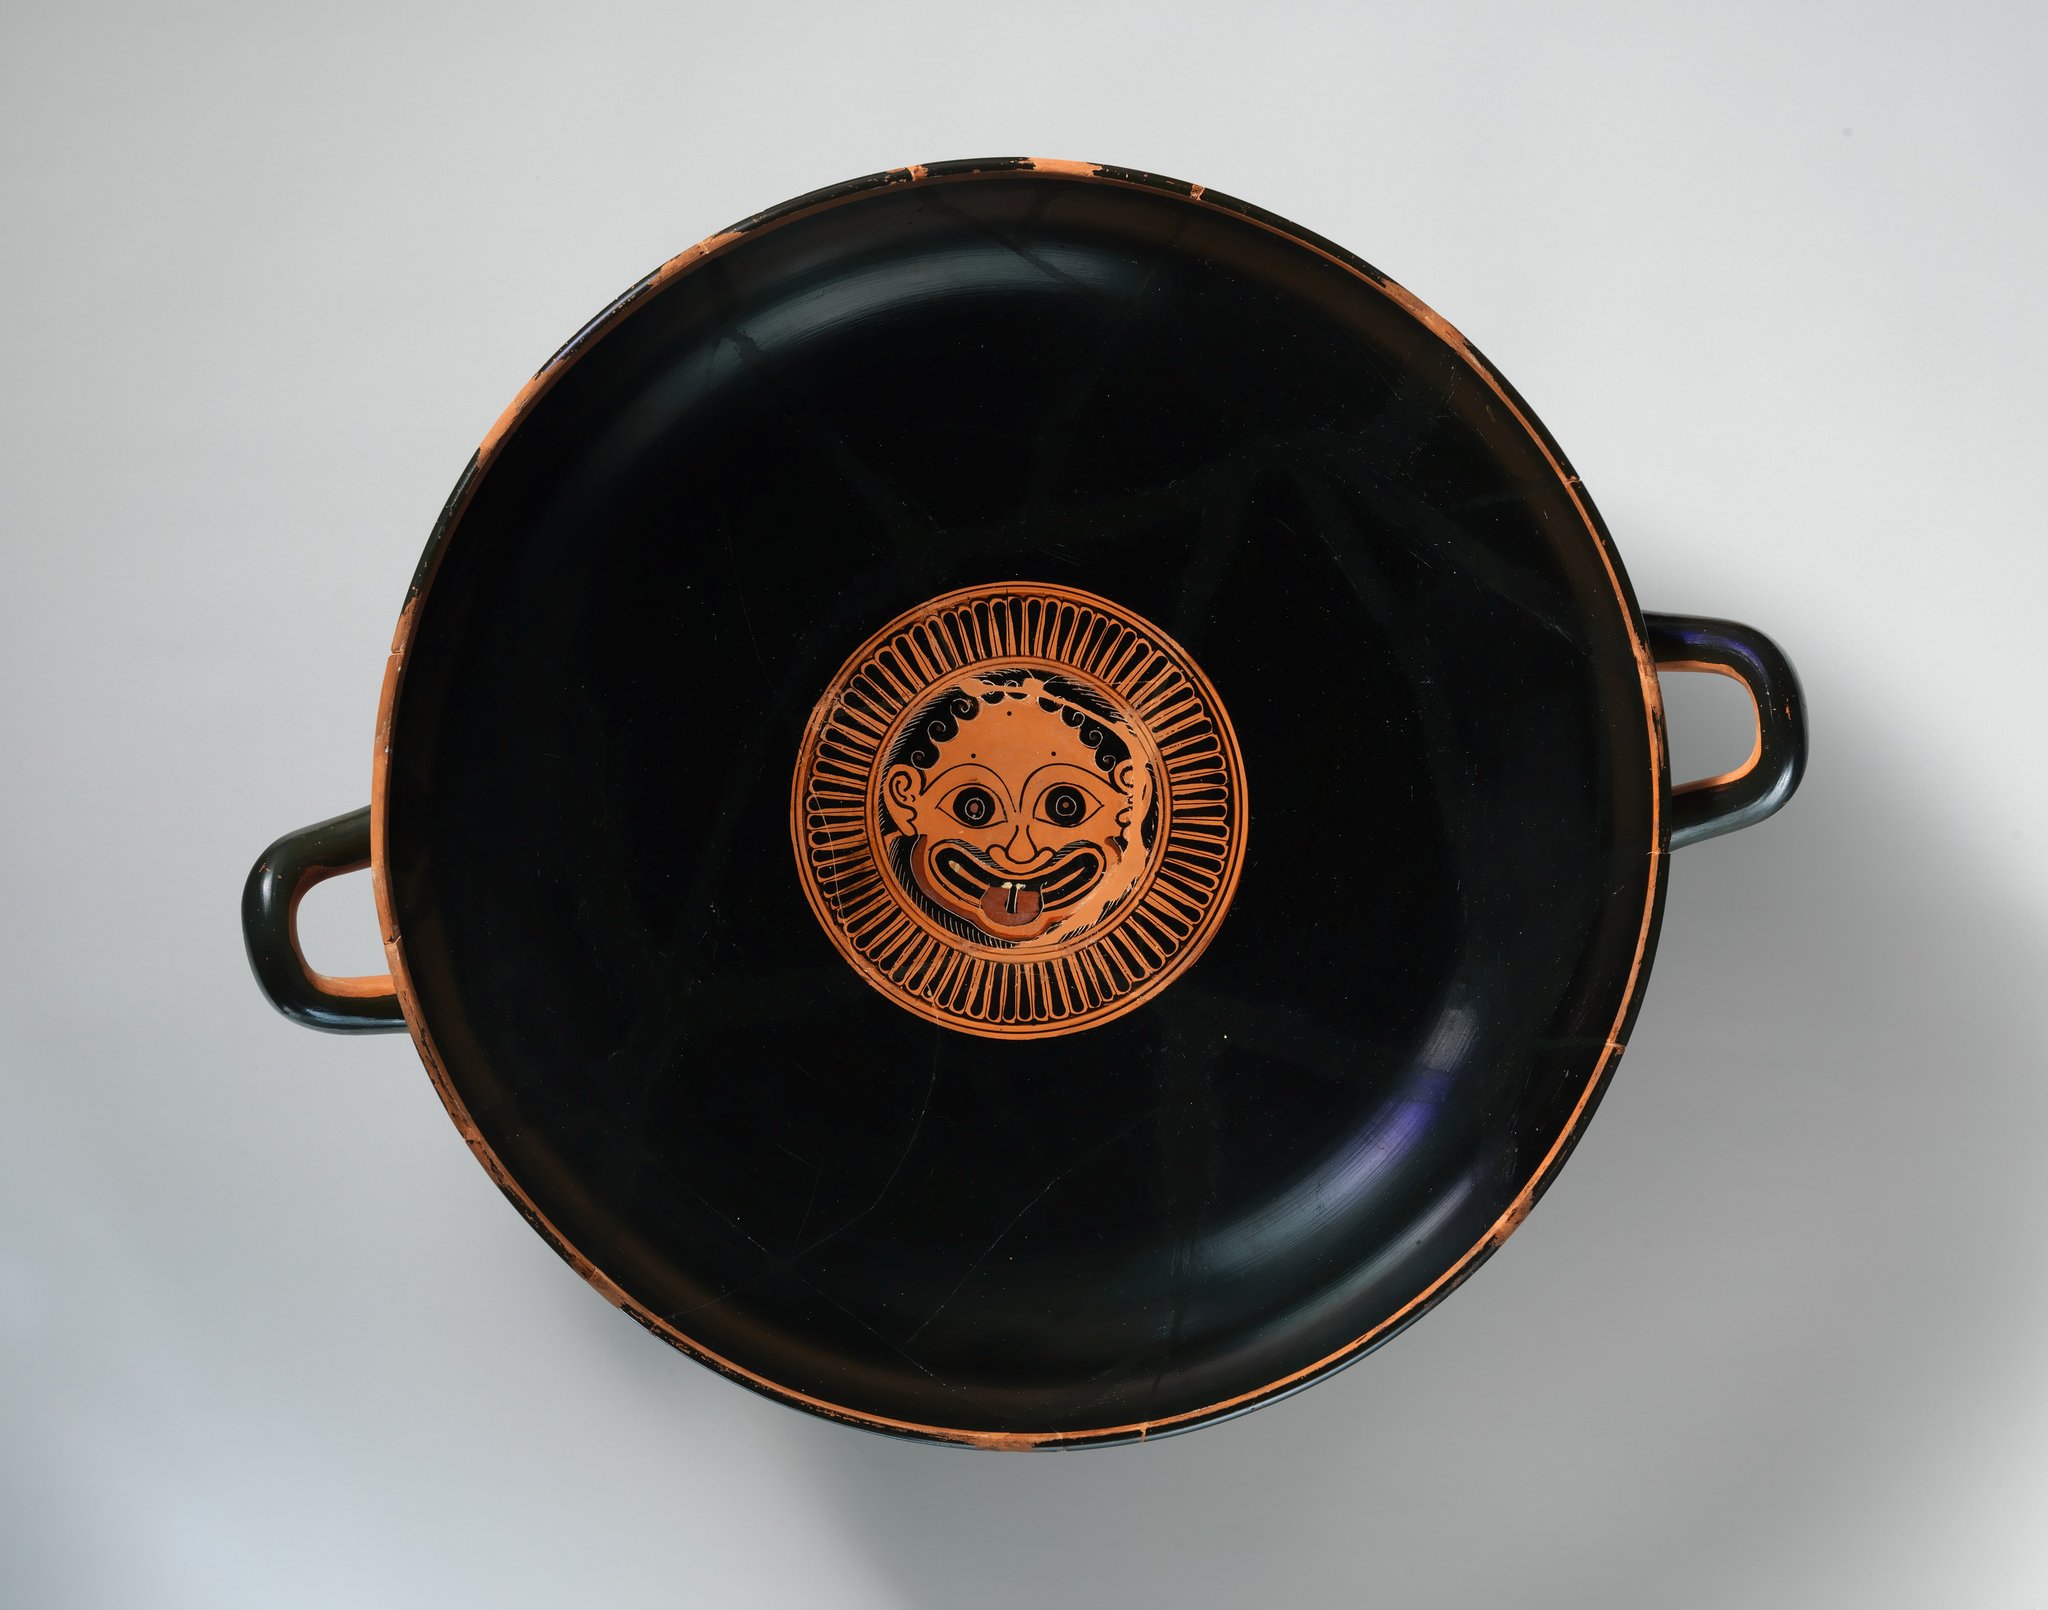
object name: kylix, eye cup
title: Terracotta kylix: eye-cup (drinking cup)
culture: greek, attic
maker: nikosthenes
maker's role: artist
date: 530 BCE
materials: terracotta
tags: eyes,dionysus,maenads,satyrs,horses,chariots,gorgons